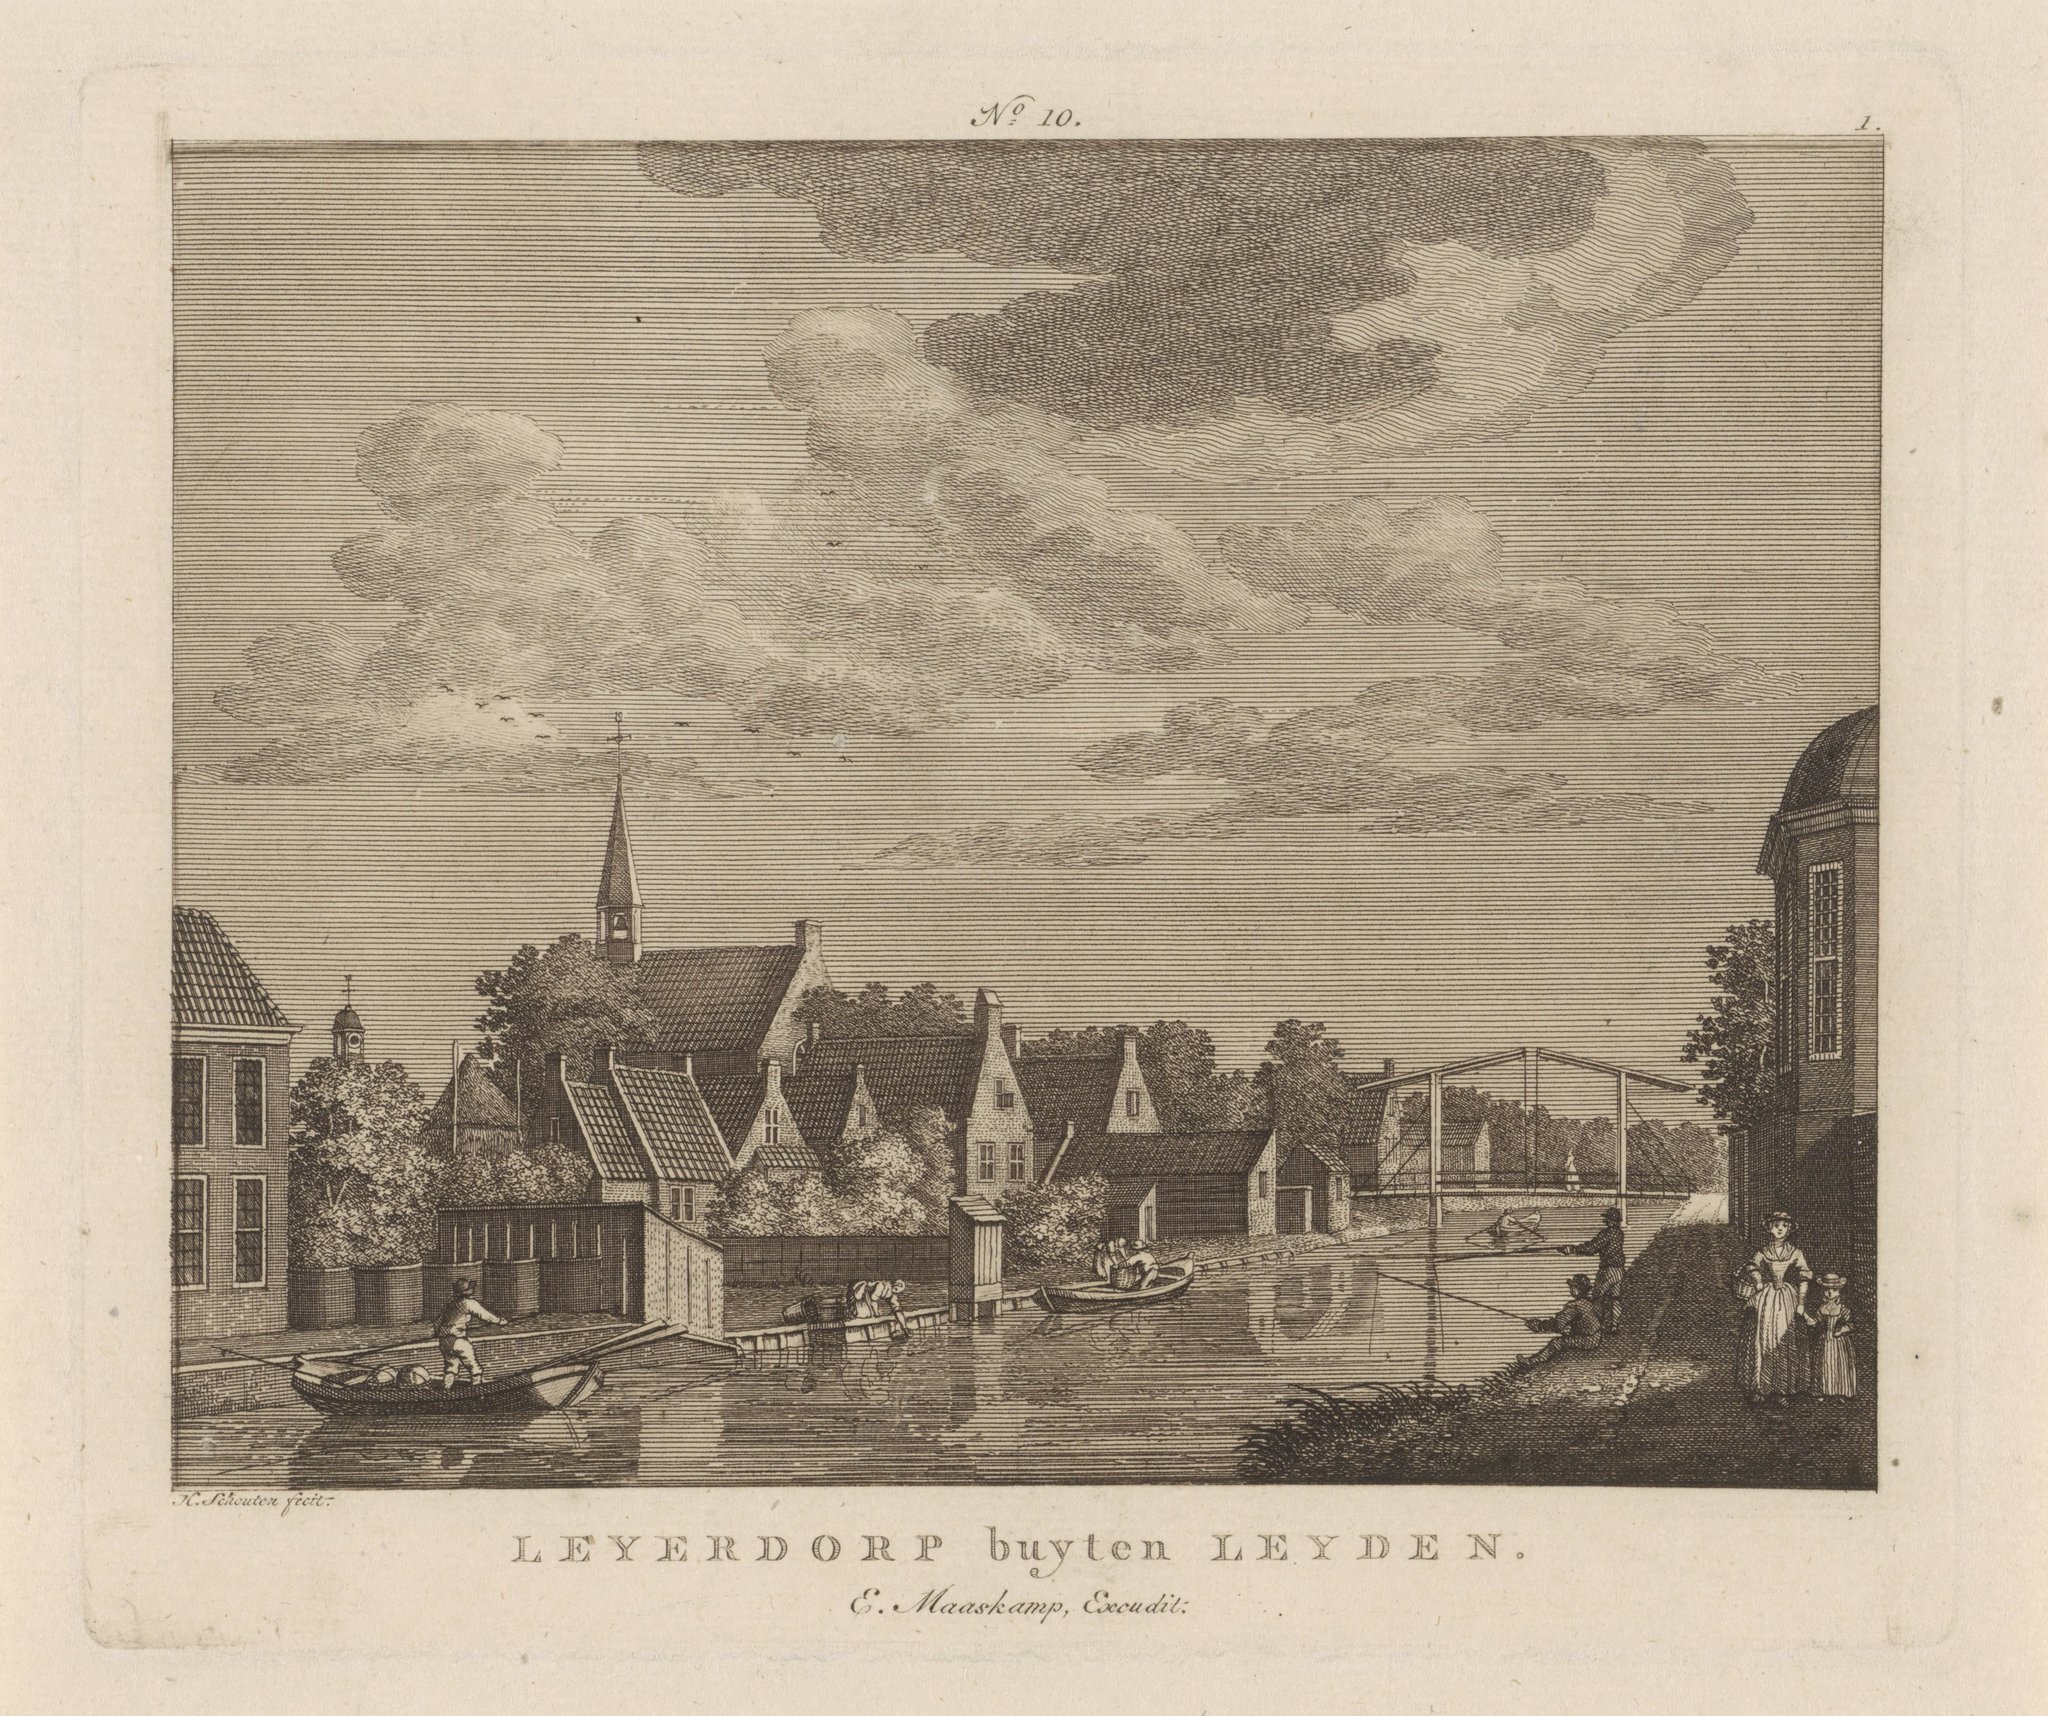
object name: print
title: Leyerdorp buyten Leyden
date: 1762-1822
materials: paper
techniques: etching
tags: leiderdorp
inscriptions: collector's mark: Lugt 2228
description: Gezicht op Leiderdorp met ophaalbrug en links de kerk. Bovenaan genummerd "10", rechtsboven genummerd "1".